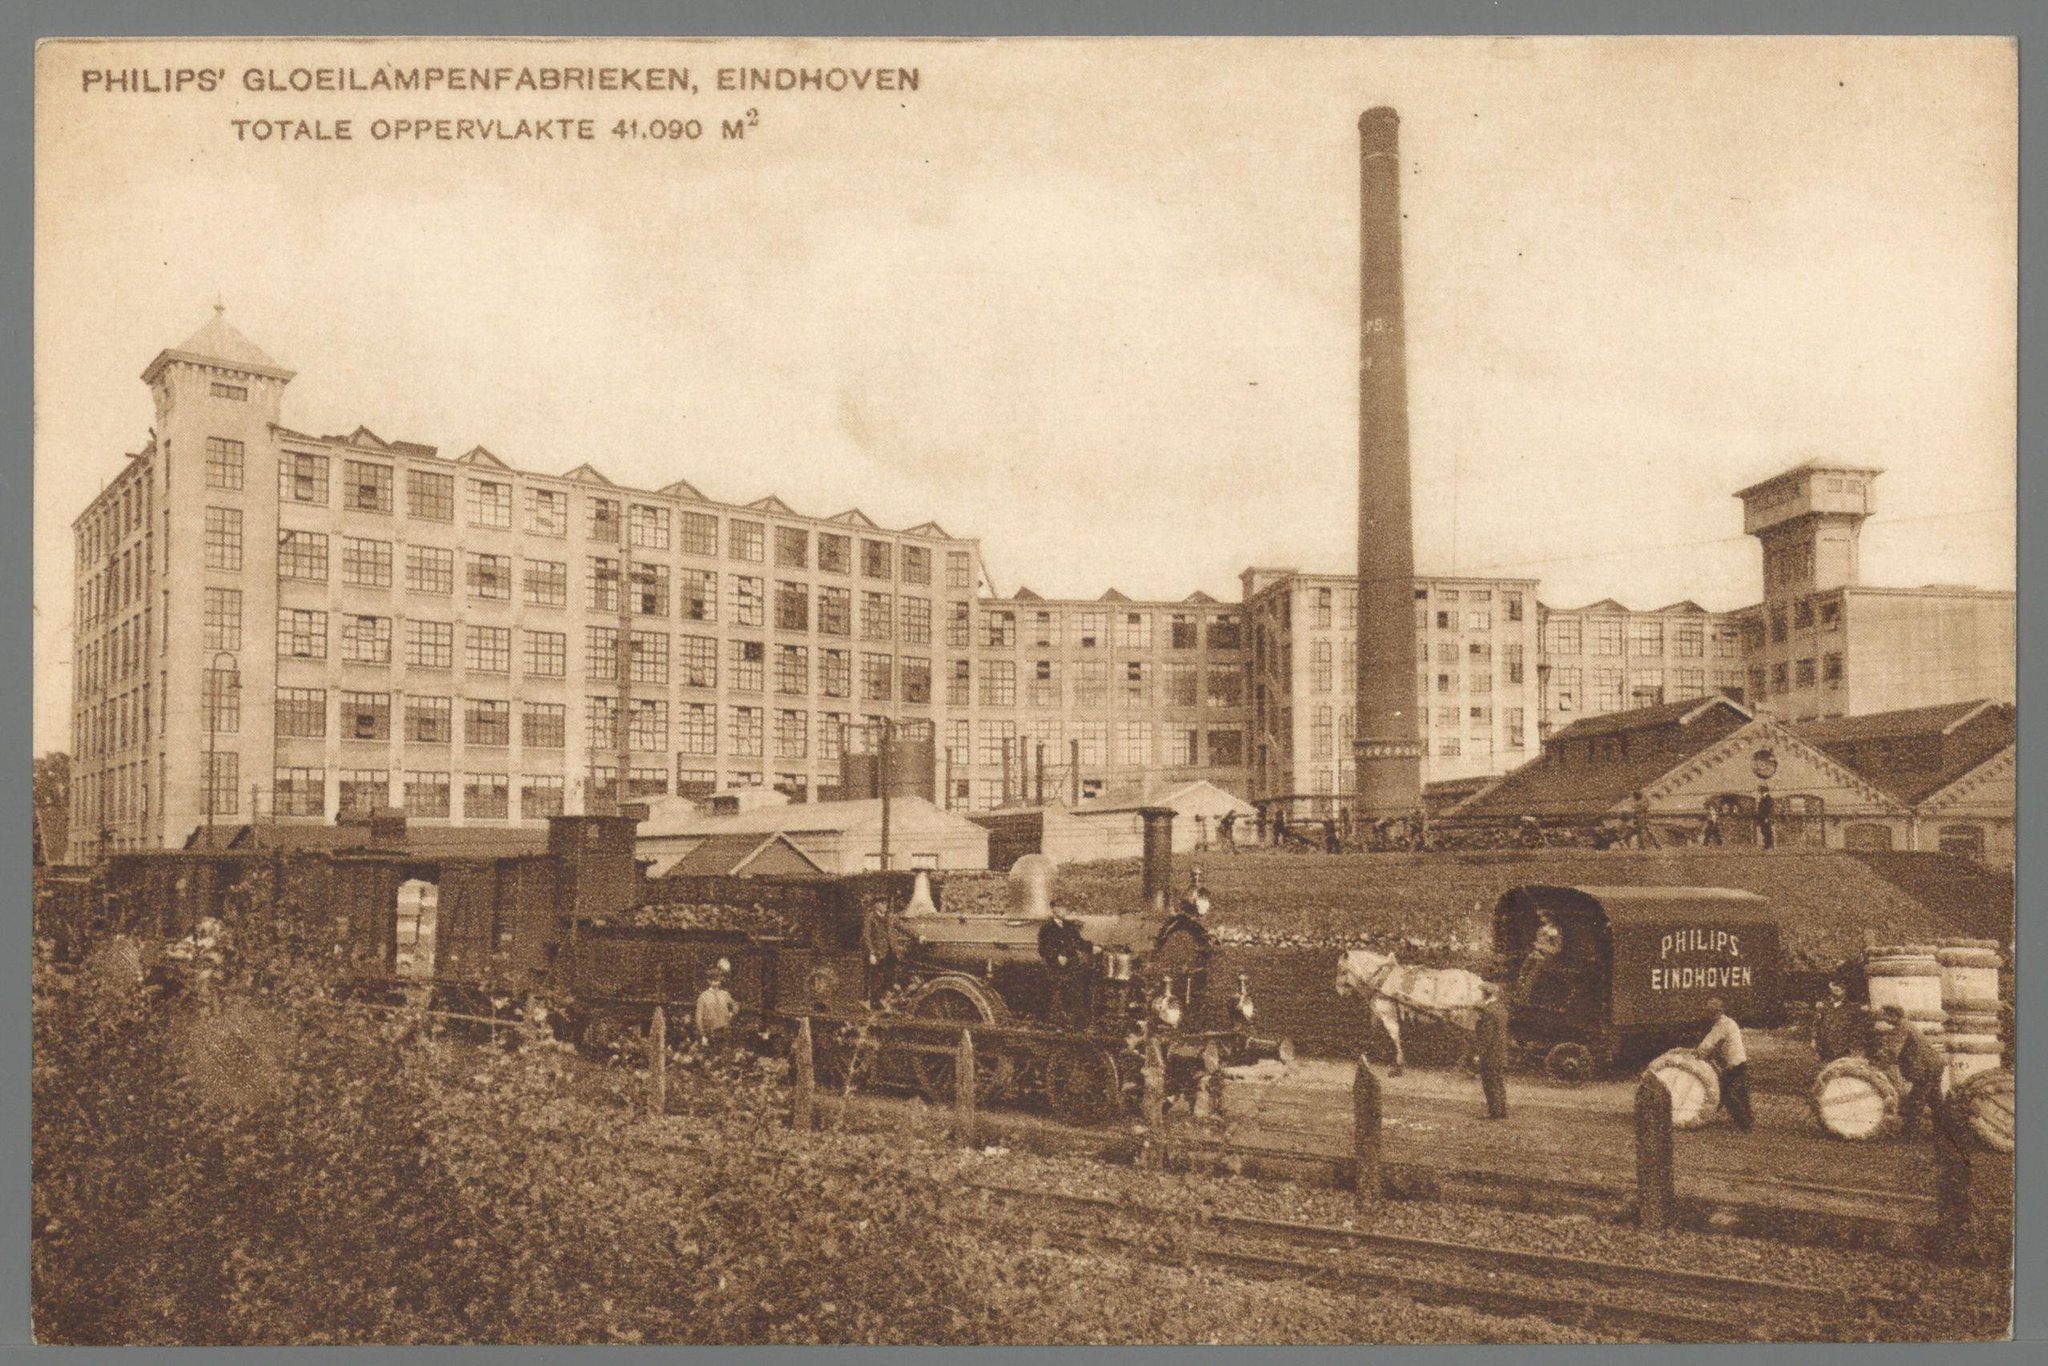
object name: ansichtkaart, prentbriefkaart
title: Philips' gloeilampenfabrieken, Eindhoven. Totale oppervlakte 41.090 m²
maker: Anonymous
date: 1912-1930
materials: cardboard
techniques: rotogravure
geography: eindhoven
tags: four-wheeled vehicle drawn by one animal, factory-building, steam locomotive